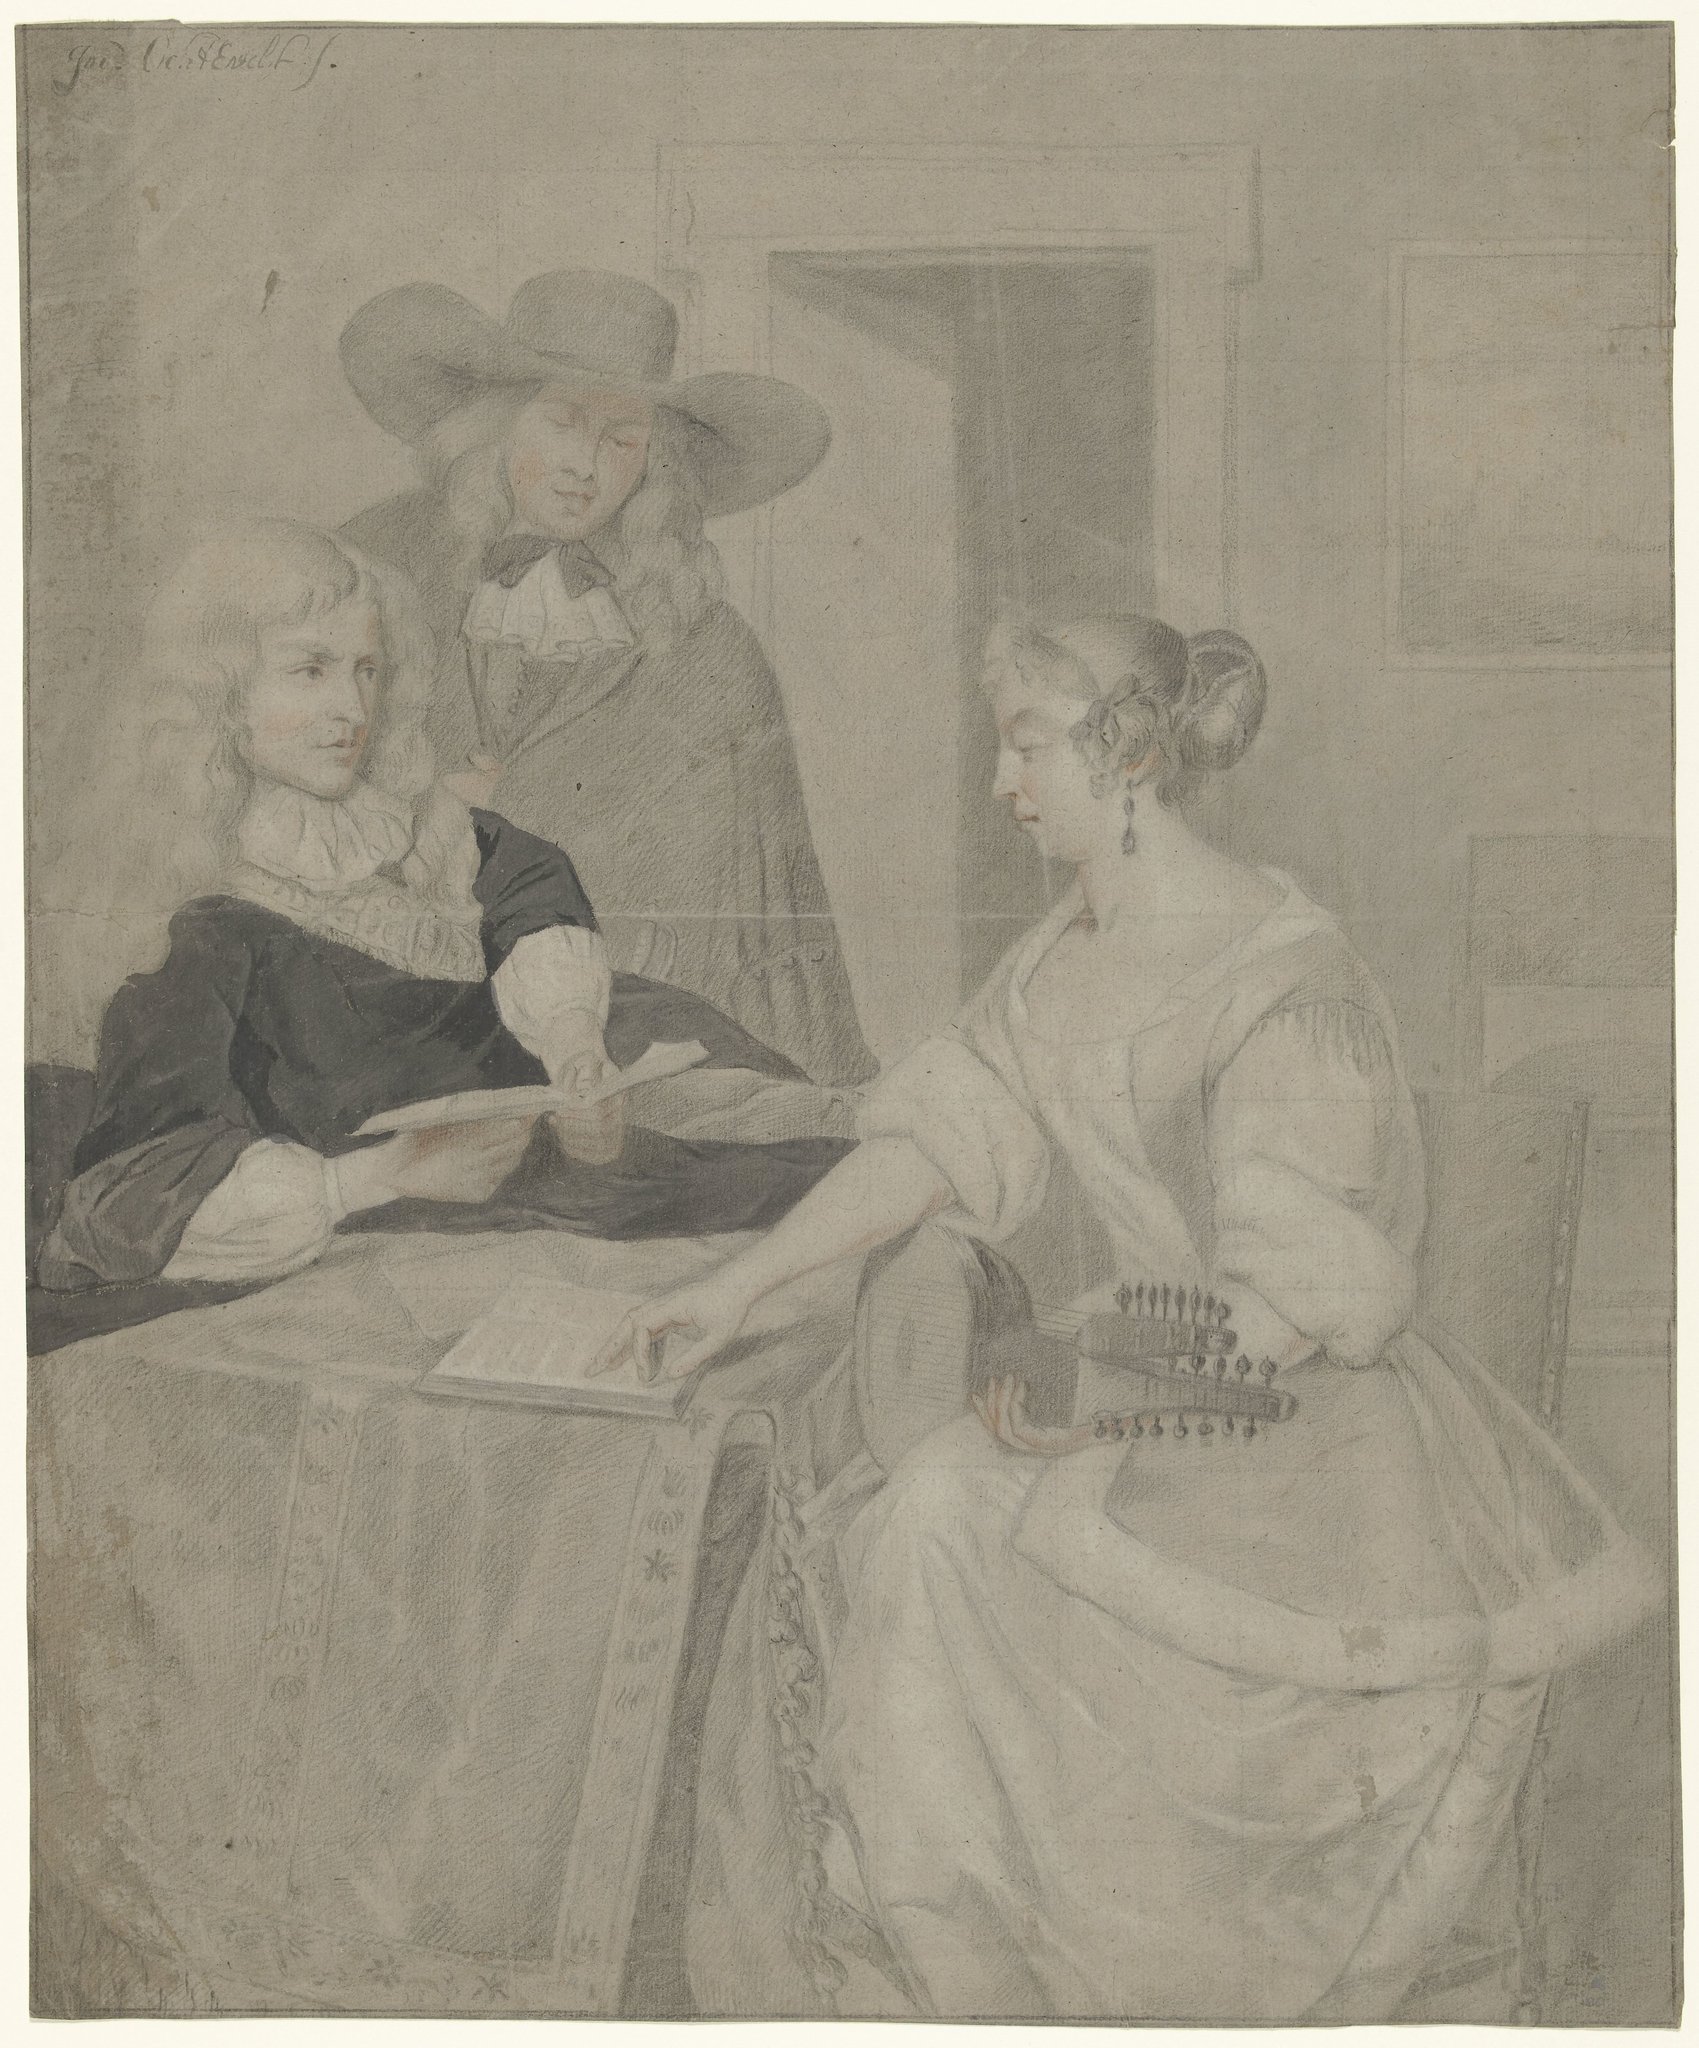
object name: drawing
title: Musicerend paar aan tafel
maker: Anonymous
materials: chalk, paper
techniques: brush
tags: instrumental and vocal music together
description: De tekening reproduceert het schilderij van Gerard ter Borch de Jonge in het Cincinnati Art Museum.